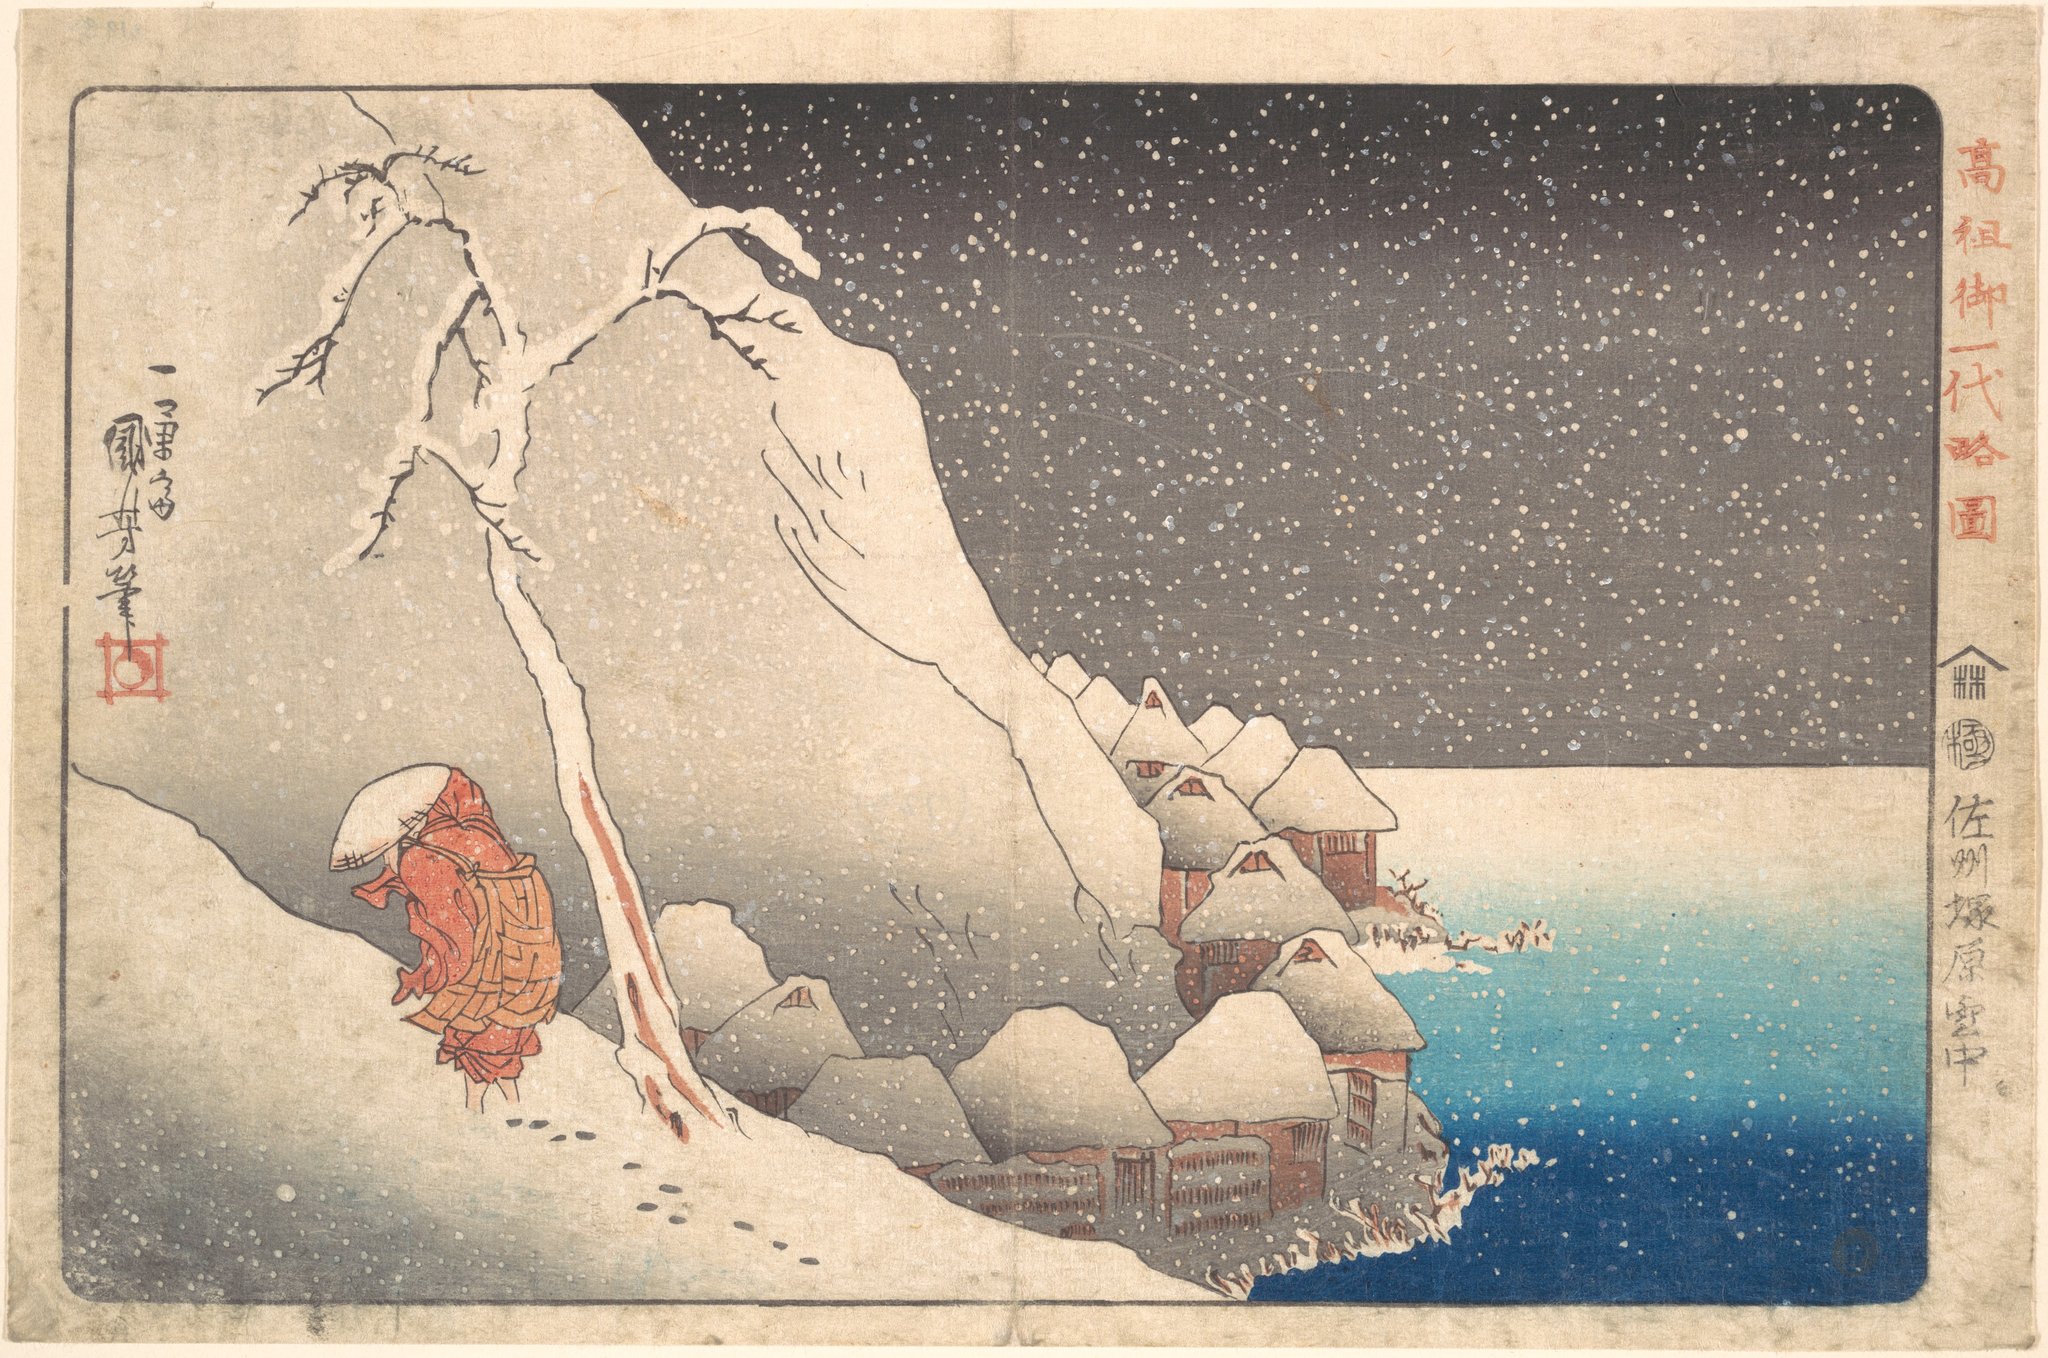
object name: print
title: Concise Illustrated Biography of Monk Nichiren: In Snow at Tsukahara on Sado Island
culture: japanese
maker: utagawa kuniyoshi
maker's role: artist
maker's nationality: japanese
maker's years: 1797-1861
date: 1835-1836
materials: ink, paper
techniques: woodblock print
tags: human figures,trees,rain,snow